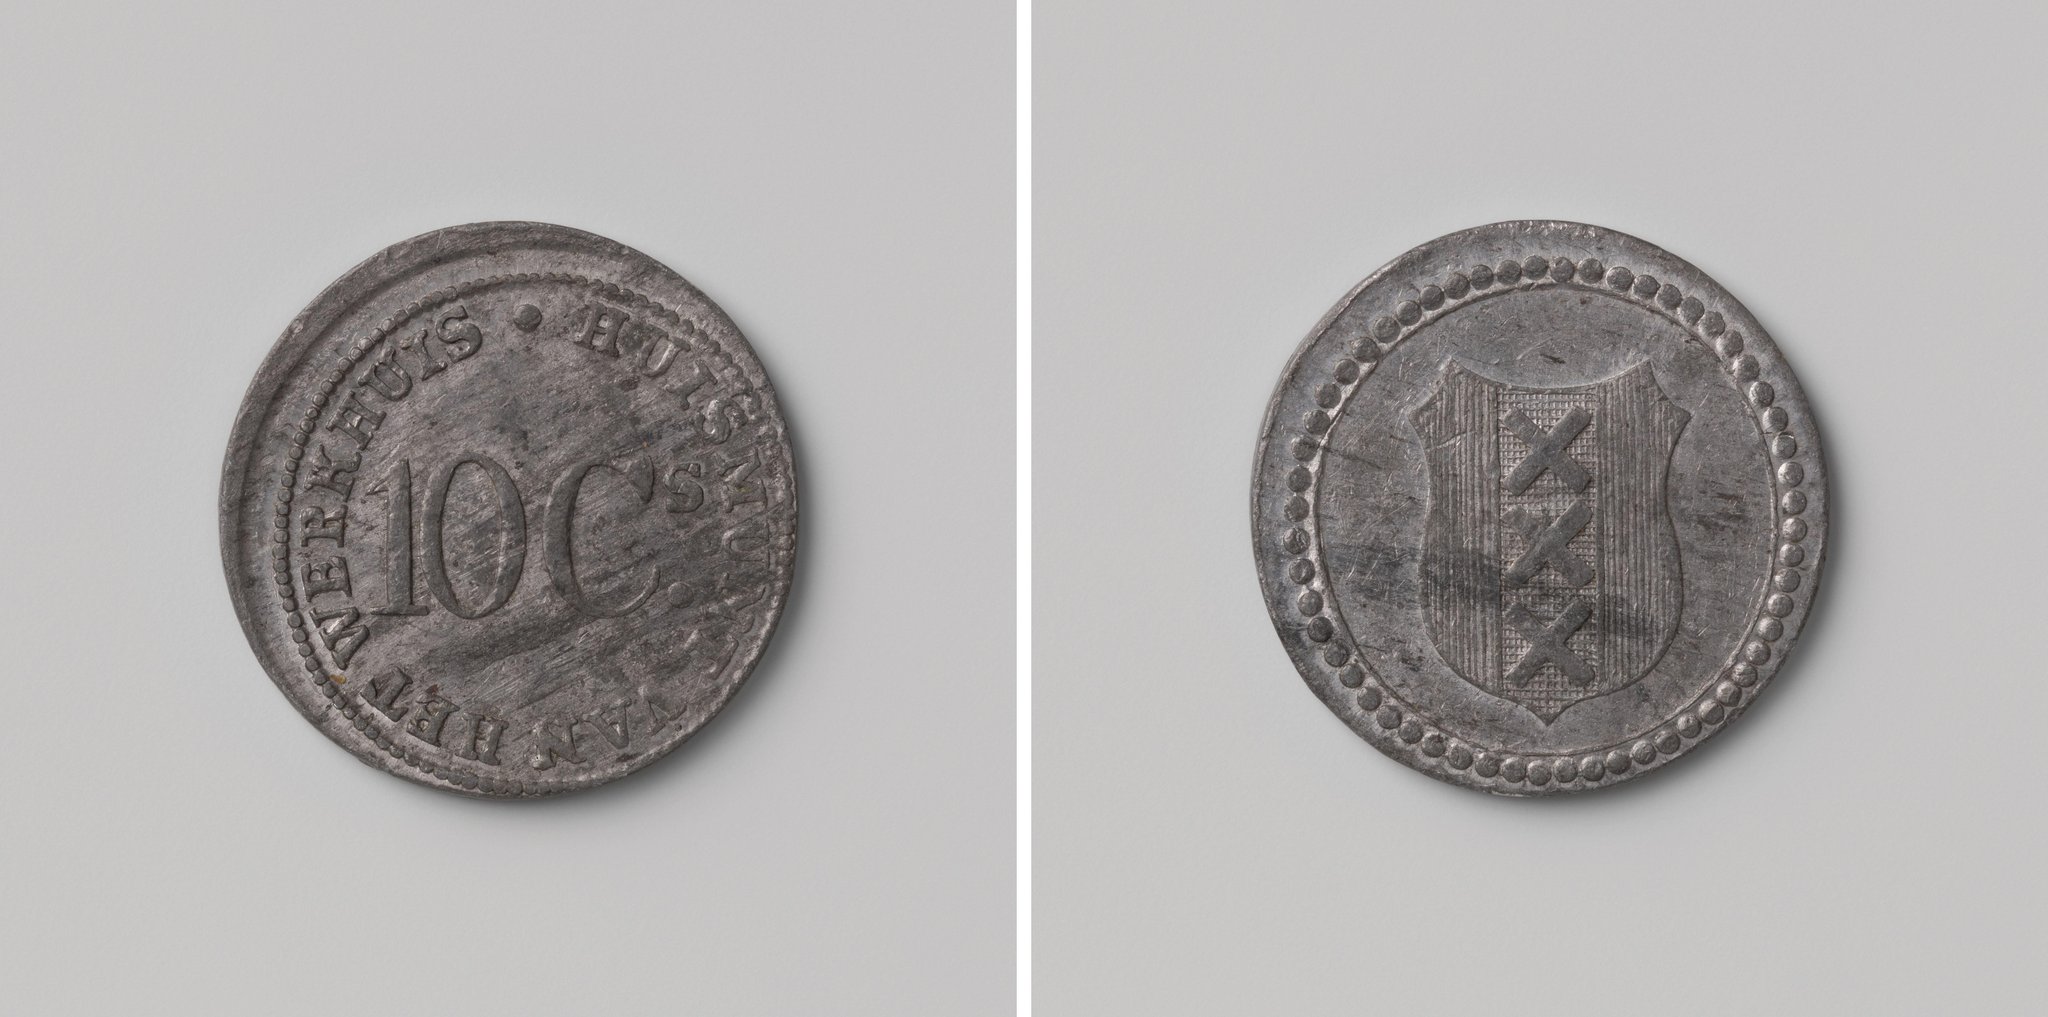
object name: tien cent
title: Werkhuis te Amsterdam, huismunt ter waarde van tien cent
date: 1824-1837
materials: lead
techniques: striking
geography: amsterdam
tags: amsterdam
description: Voorzijde: waardeaanduiding binnen omschrift en parelrand. Keerzijde: wapenschild binnen parelrand